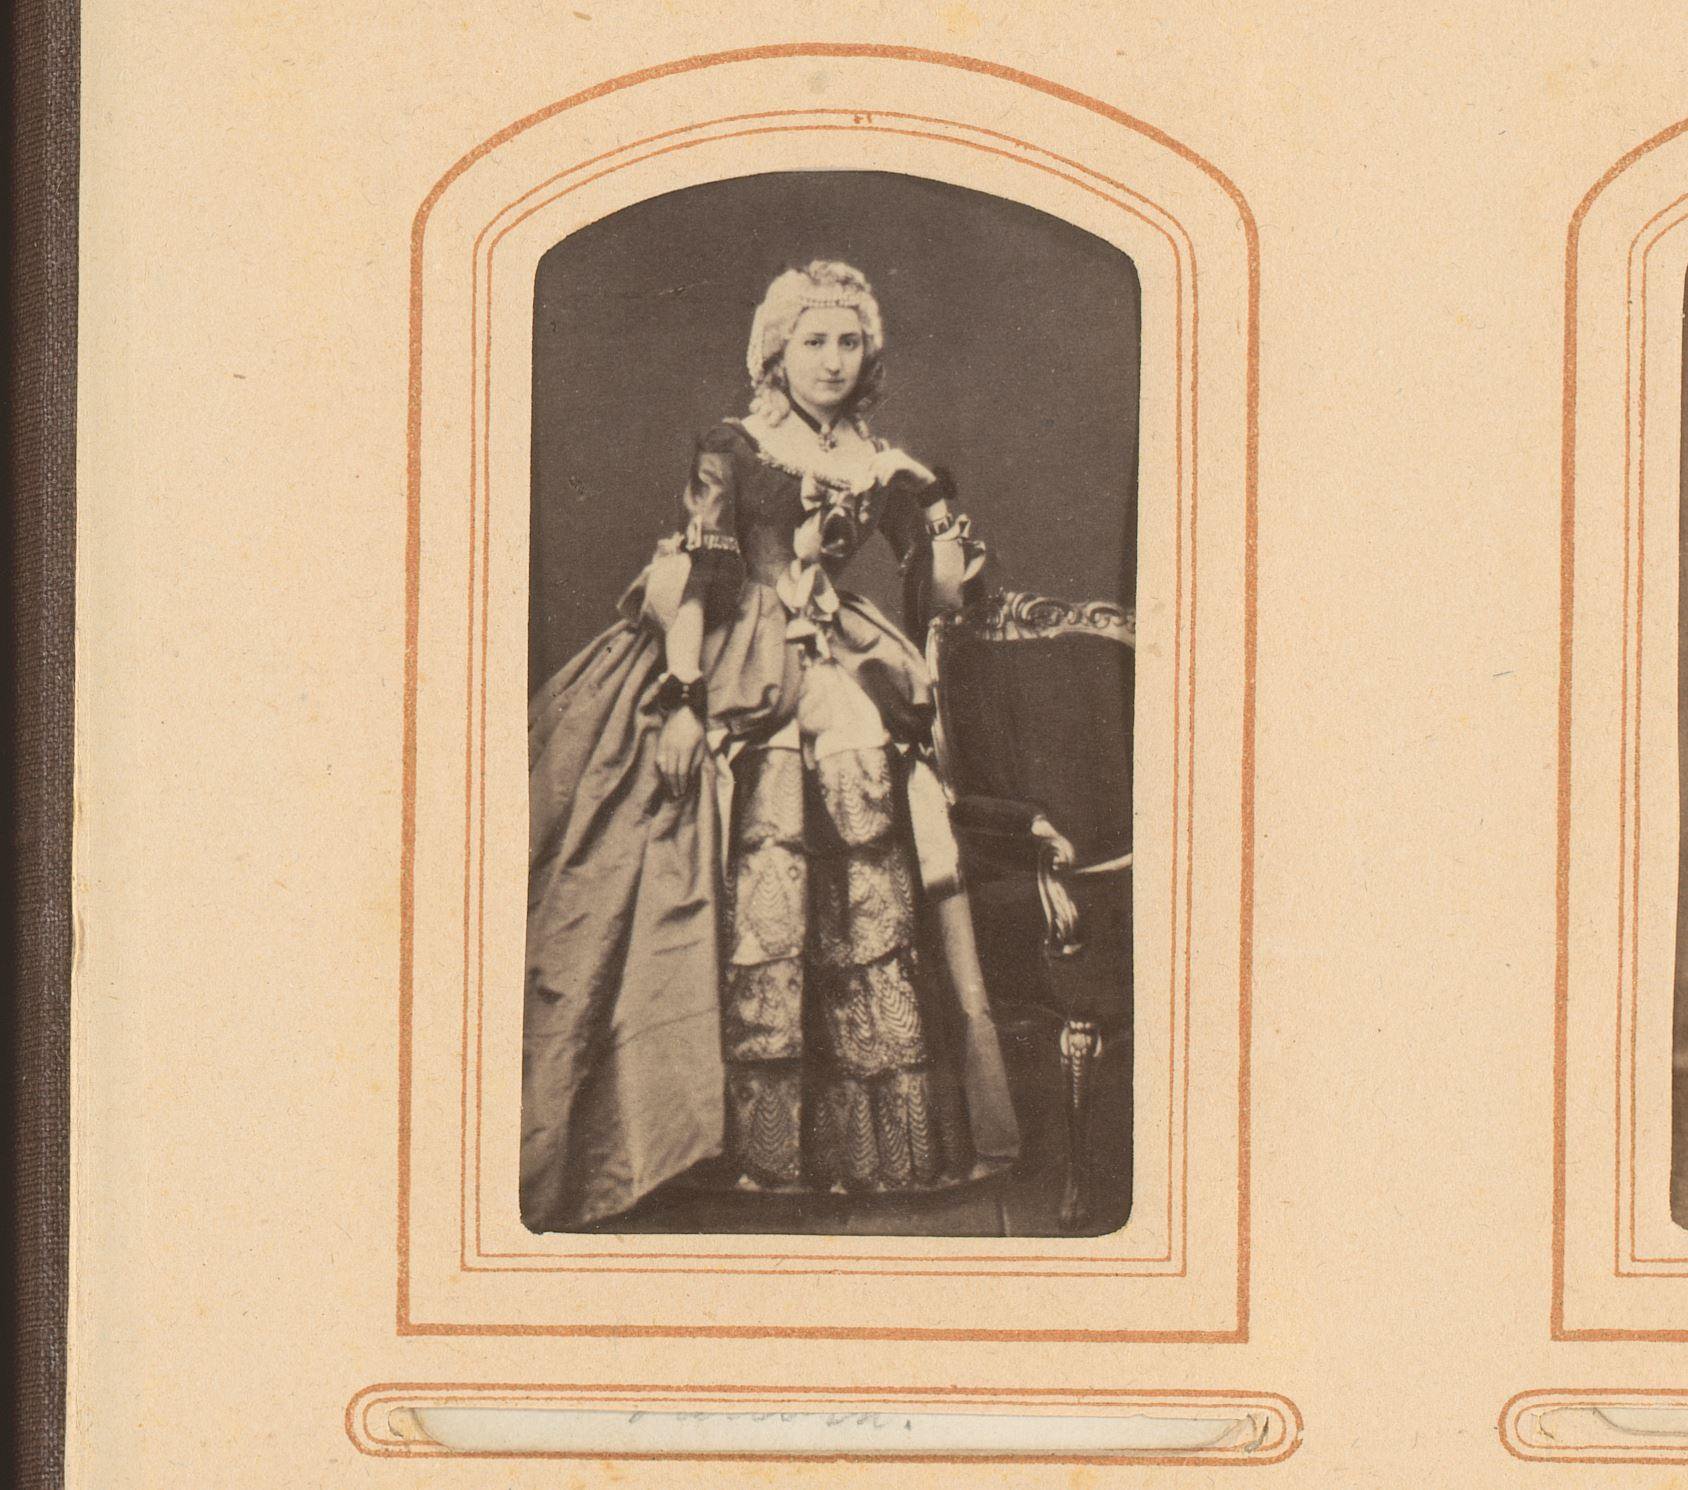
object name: album leaf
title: Portret van een staande vrouw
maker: constantin schwendler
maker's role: fotograaf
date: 1865-1894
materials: cardboard, photographic support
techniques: albumen print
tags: historical persons, standing figure - aa - female human figure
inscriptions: inscription: ‘Constantin Schwendler/ Atelier für Photographie/ Dresden/ Theaterplatz No.’, annotation: ‘[...]’